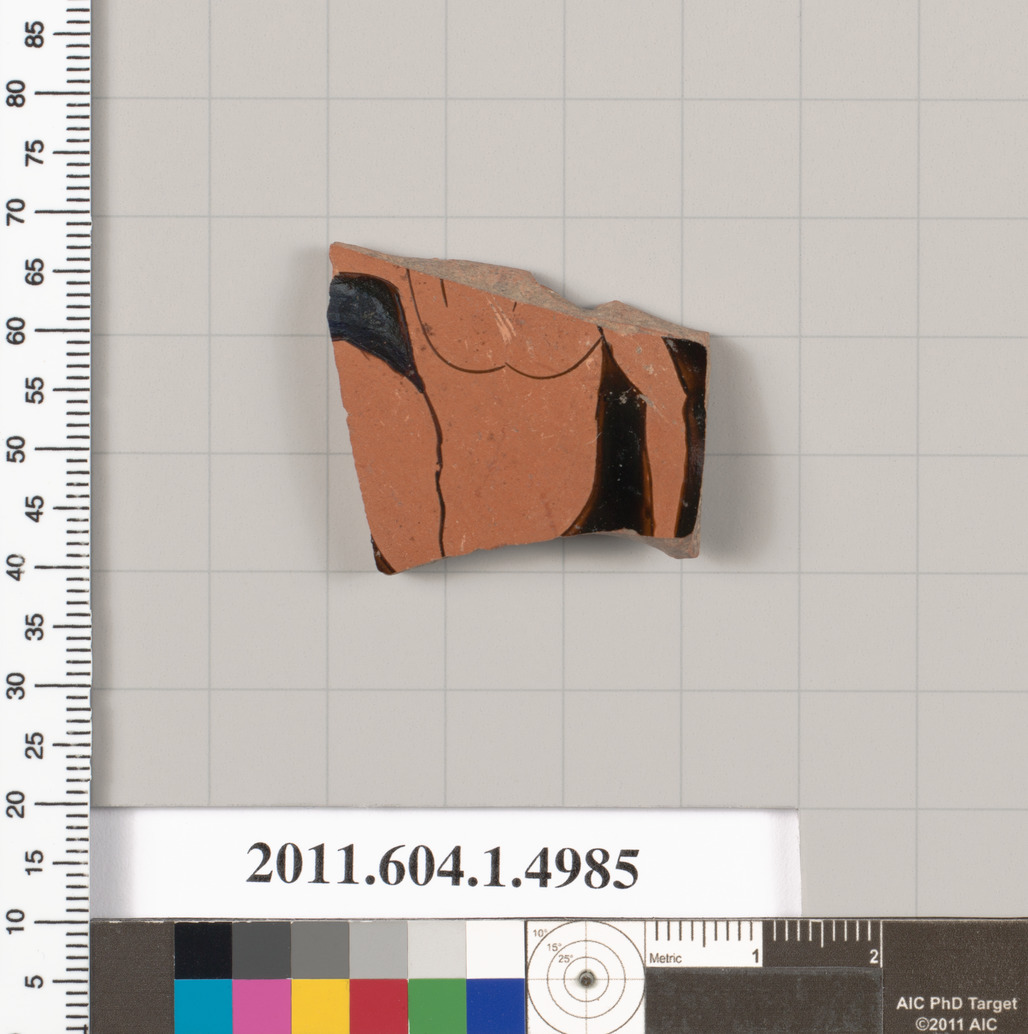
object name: kylix fragment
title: Terracotta fragment of a kylix (drinking cup)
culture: greek, attic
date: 480-470 BCE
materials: terracotta